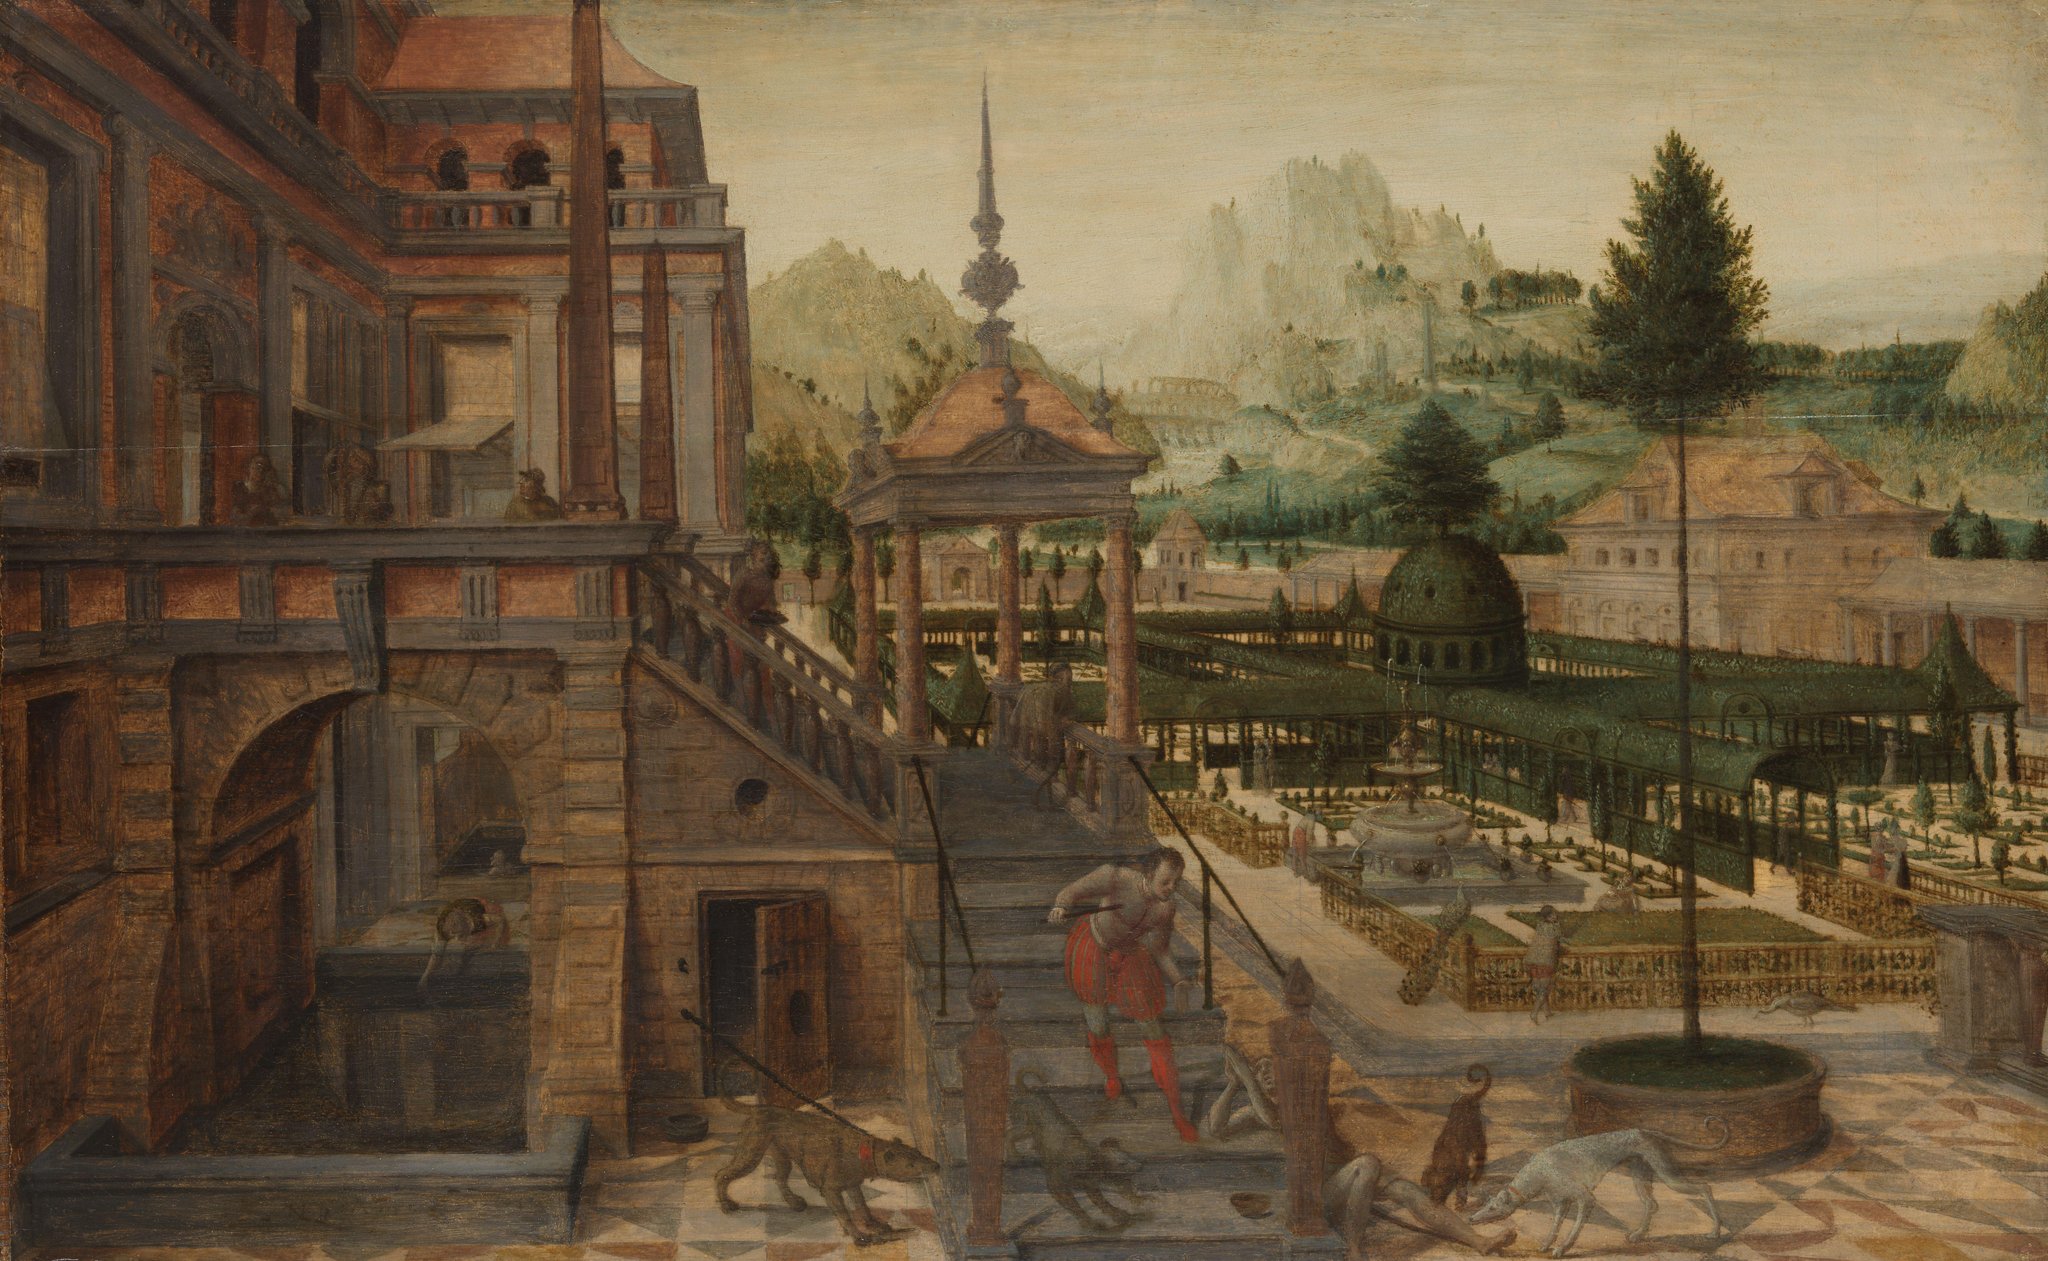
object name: painting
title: Palace Gardens with Poor Lazarus in the foreground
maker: hans vredeman de vries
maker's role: draughtsman, painter, print maker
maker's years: 1527-1607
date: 1550-1606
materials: oil, panel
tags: palace, french or architectonic garden; formal garden, the rich man (dives) is feasting, while poor lazarus is starving at the gate (dogs licking lazarus' sores) (luke 16:19-31)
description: Onderaan de trap bij de ingang van een paleis ligt de arme Lazarus te bedelen, zijn zweren worden door honden gelikt. Op de trap staan verschillende figuren. Rechts van het paleis een ornamentale tuin of park met een prieel, een fontein en pauwen.